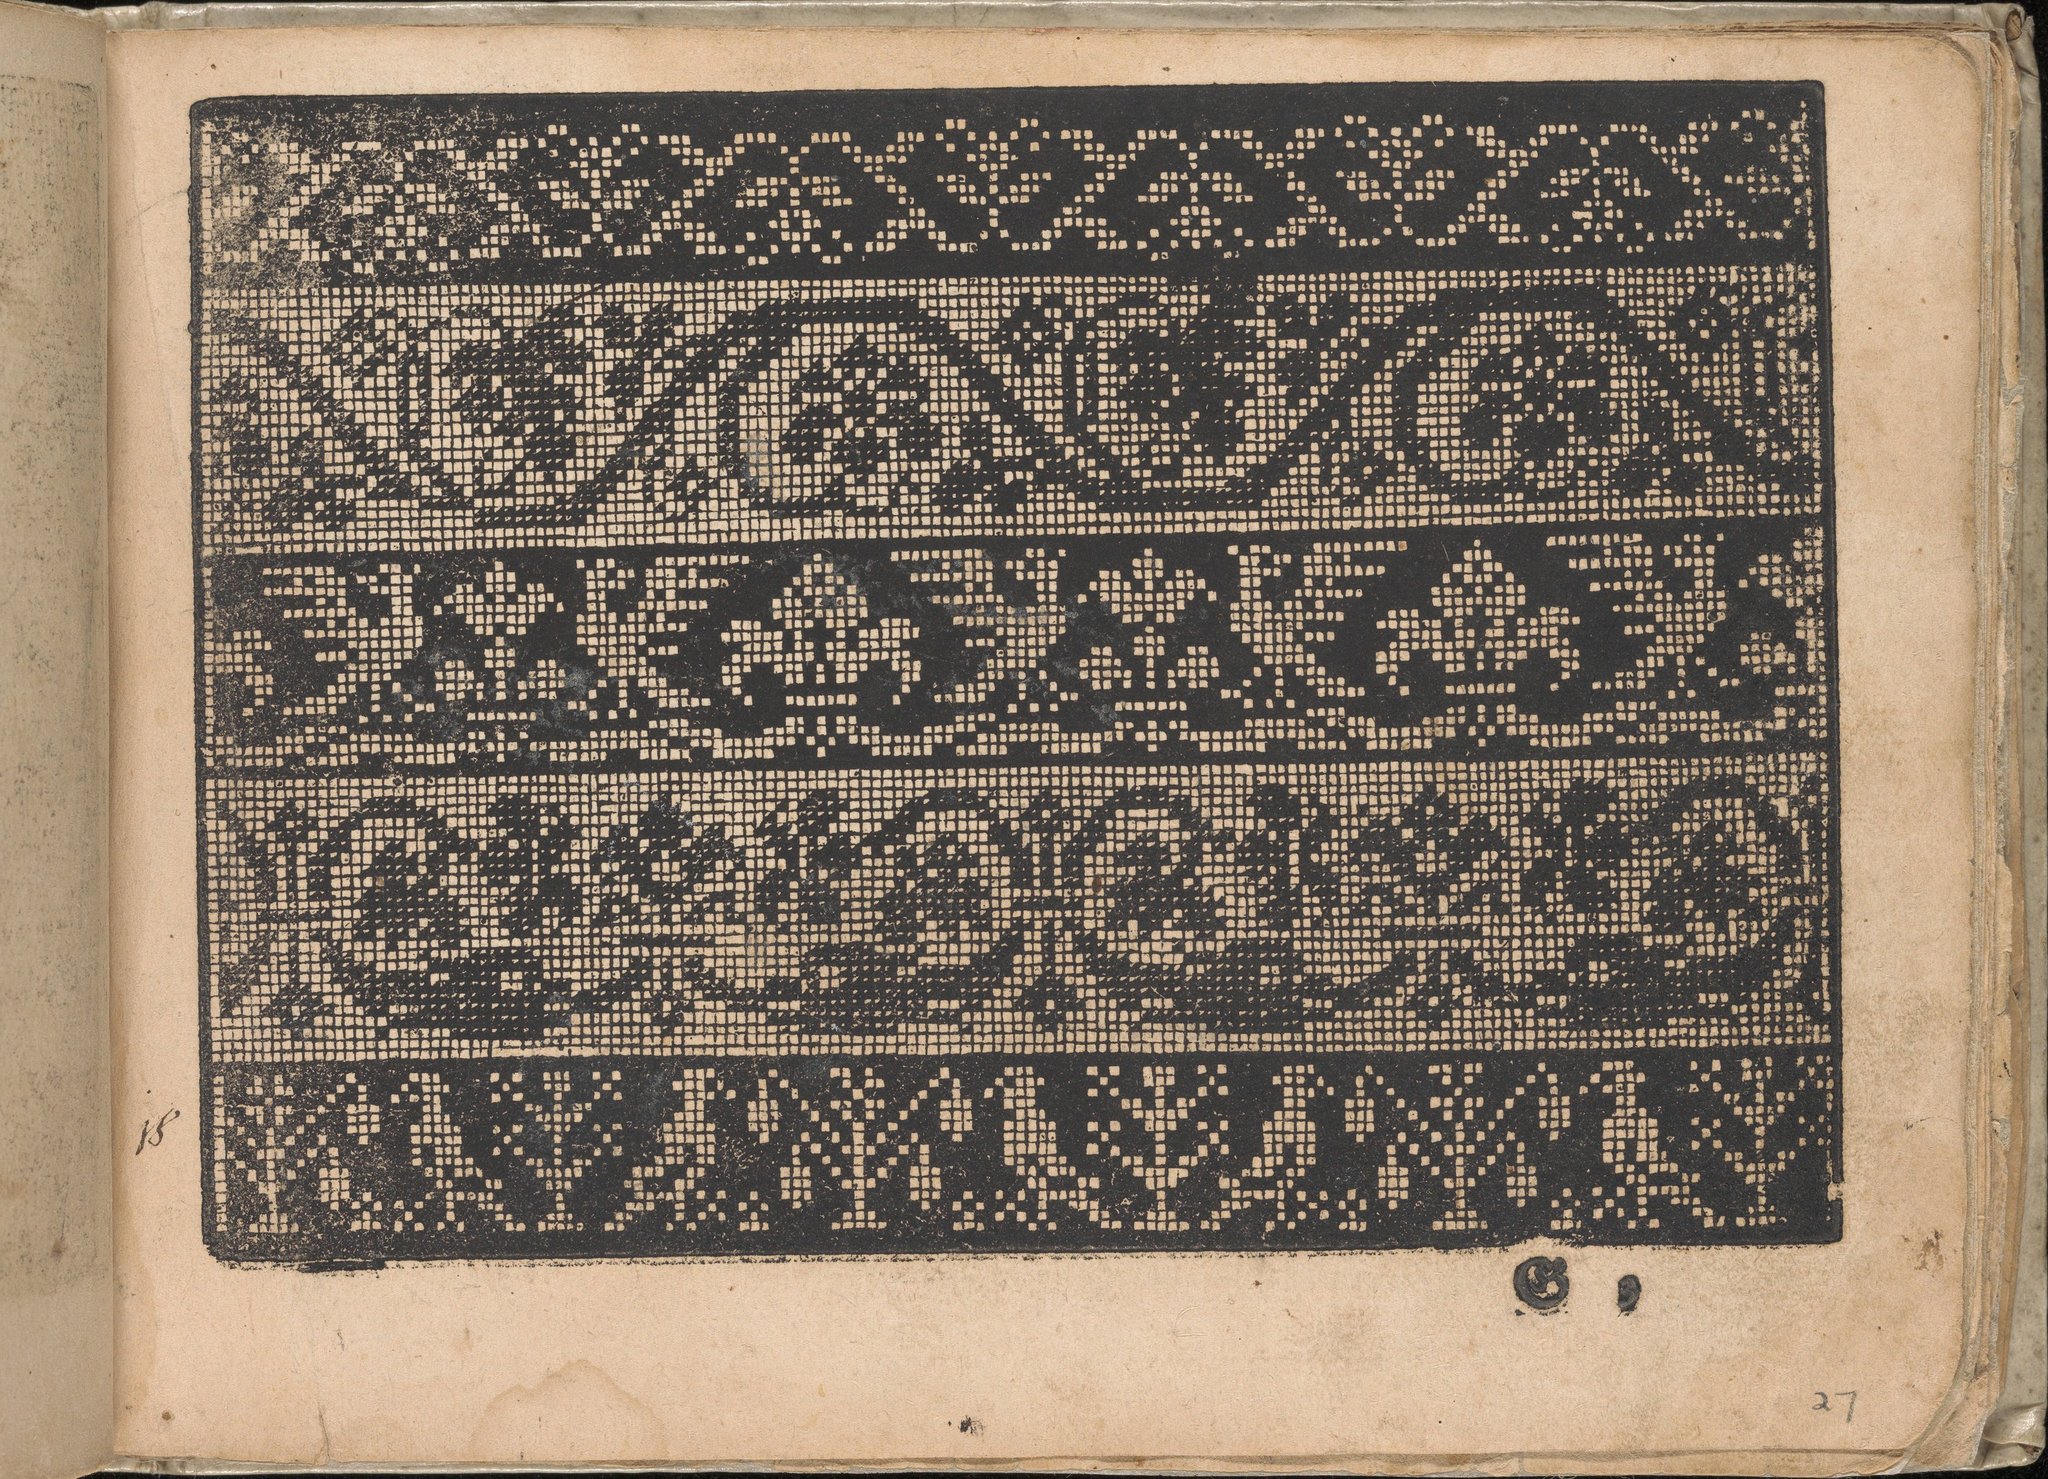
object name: book print ornament architecture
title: Neu künstlich Modelbuch (page 27r)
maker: bernhard jobin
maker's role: publisher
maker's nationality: swiss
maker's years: 1535-1597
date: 1598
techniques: woodcut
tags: birds,ornament